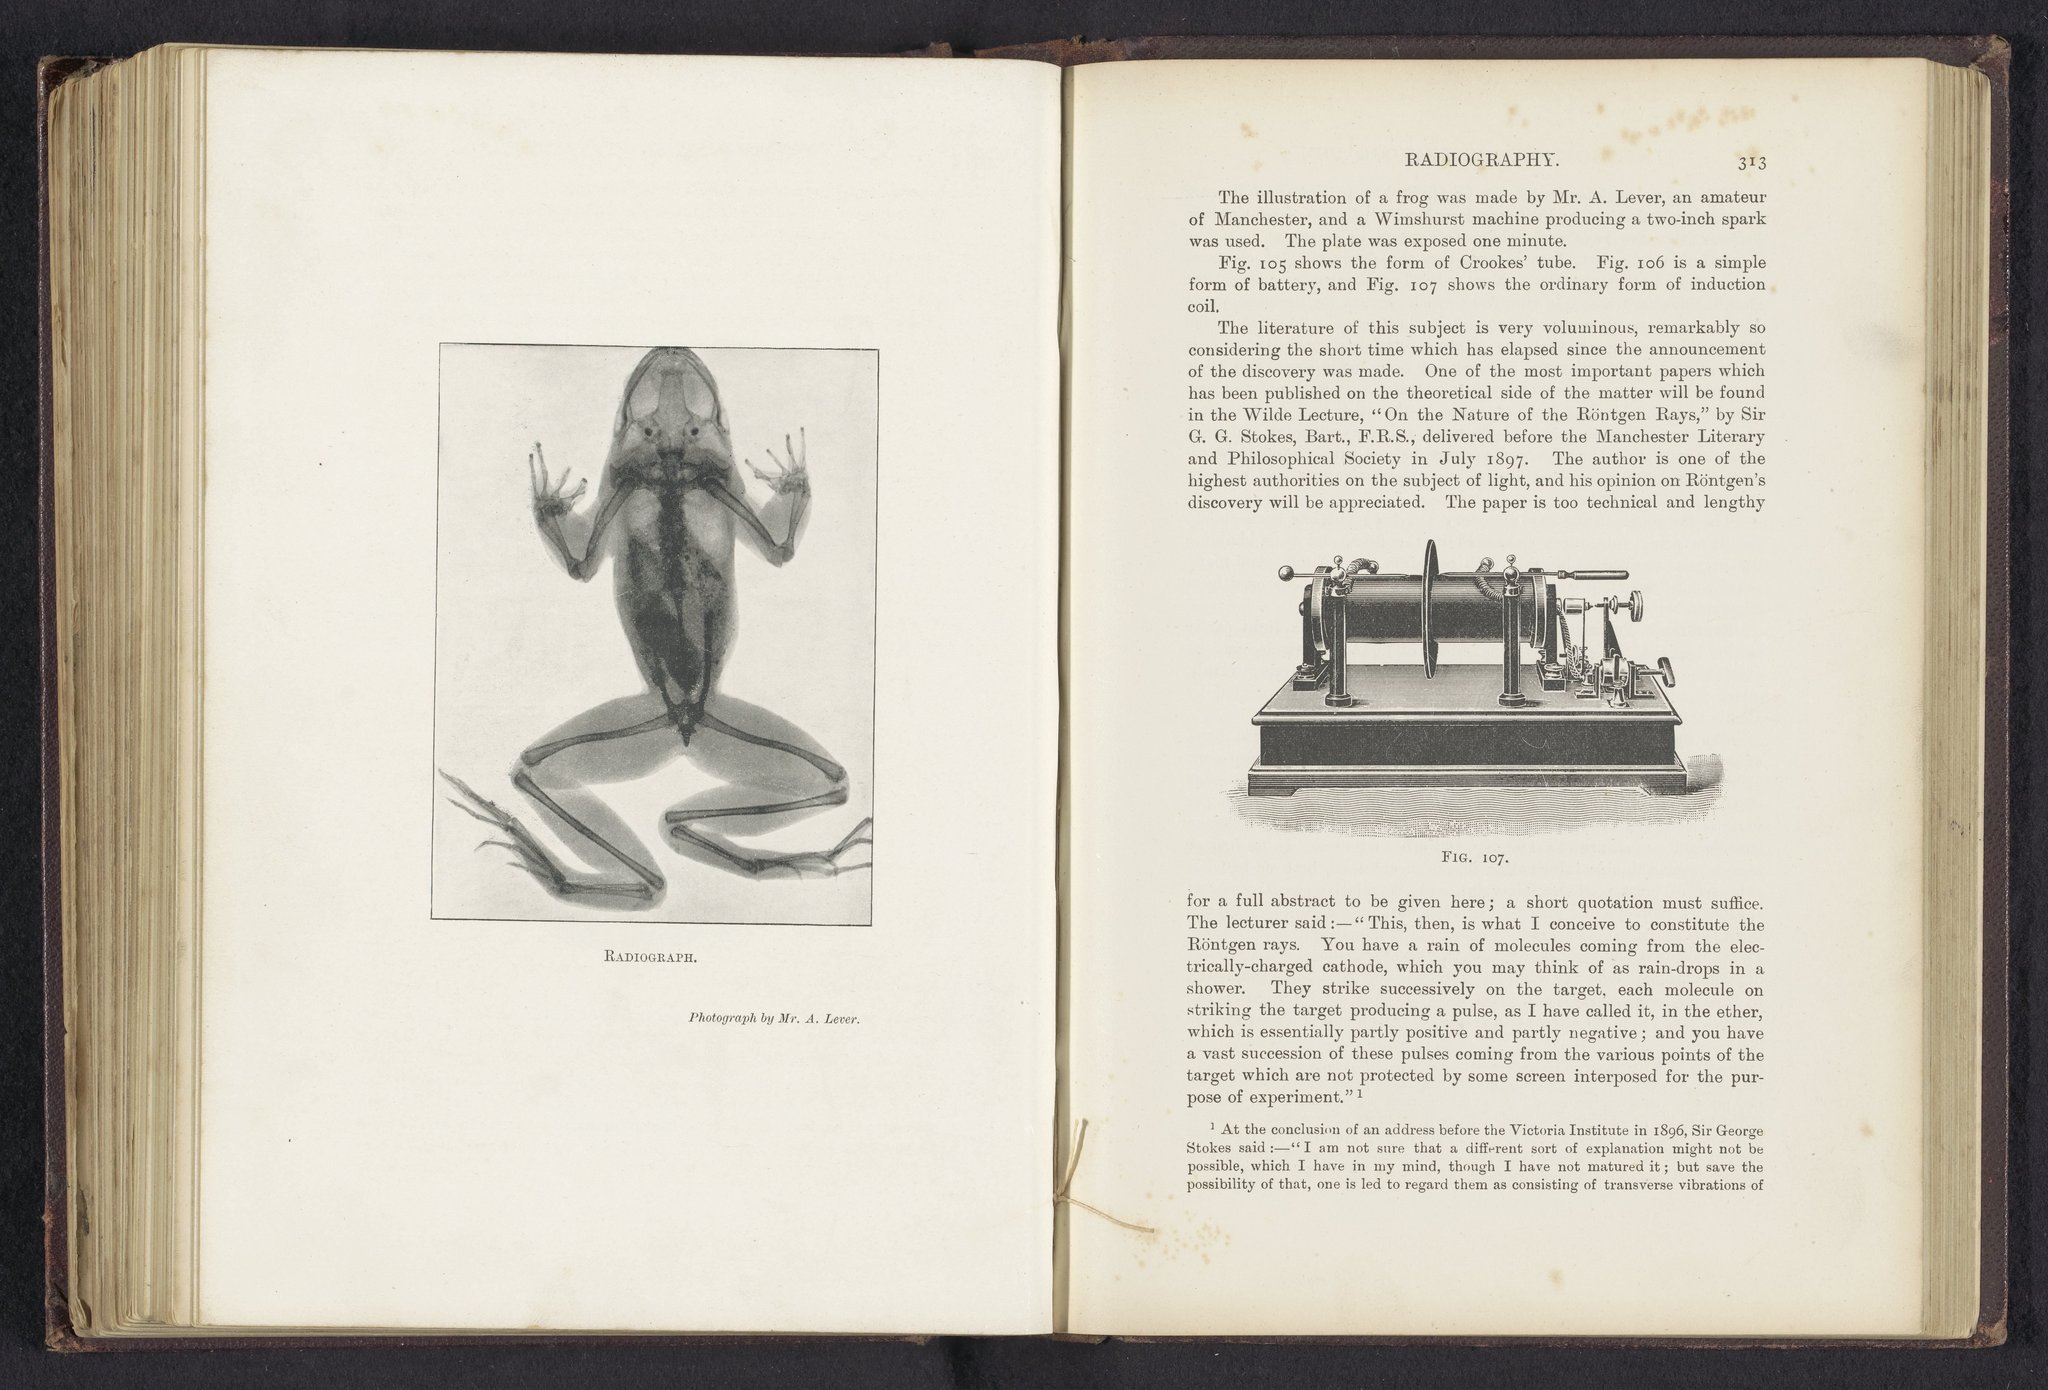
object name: page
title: Radiograph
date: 1889-1899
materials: paper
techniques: autotype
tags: tailless amphibians: frog, x-ray examination